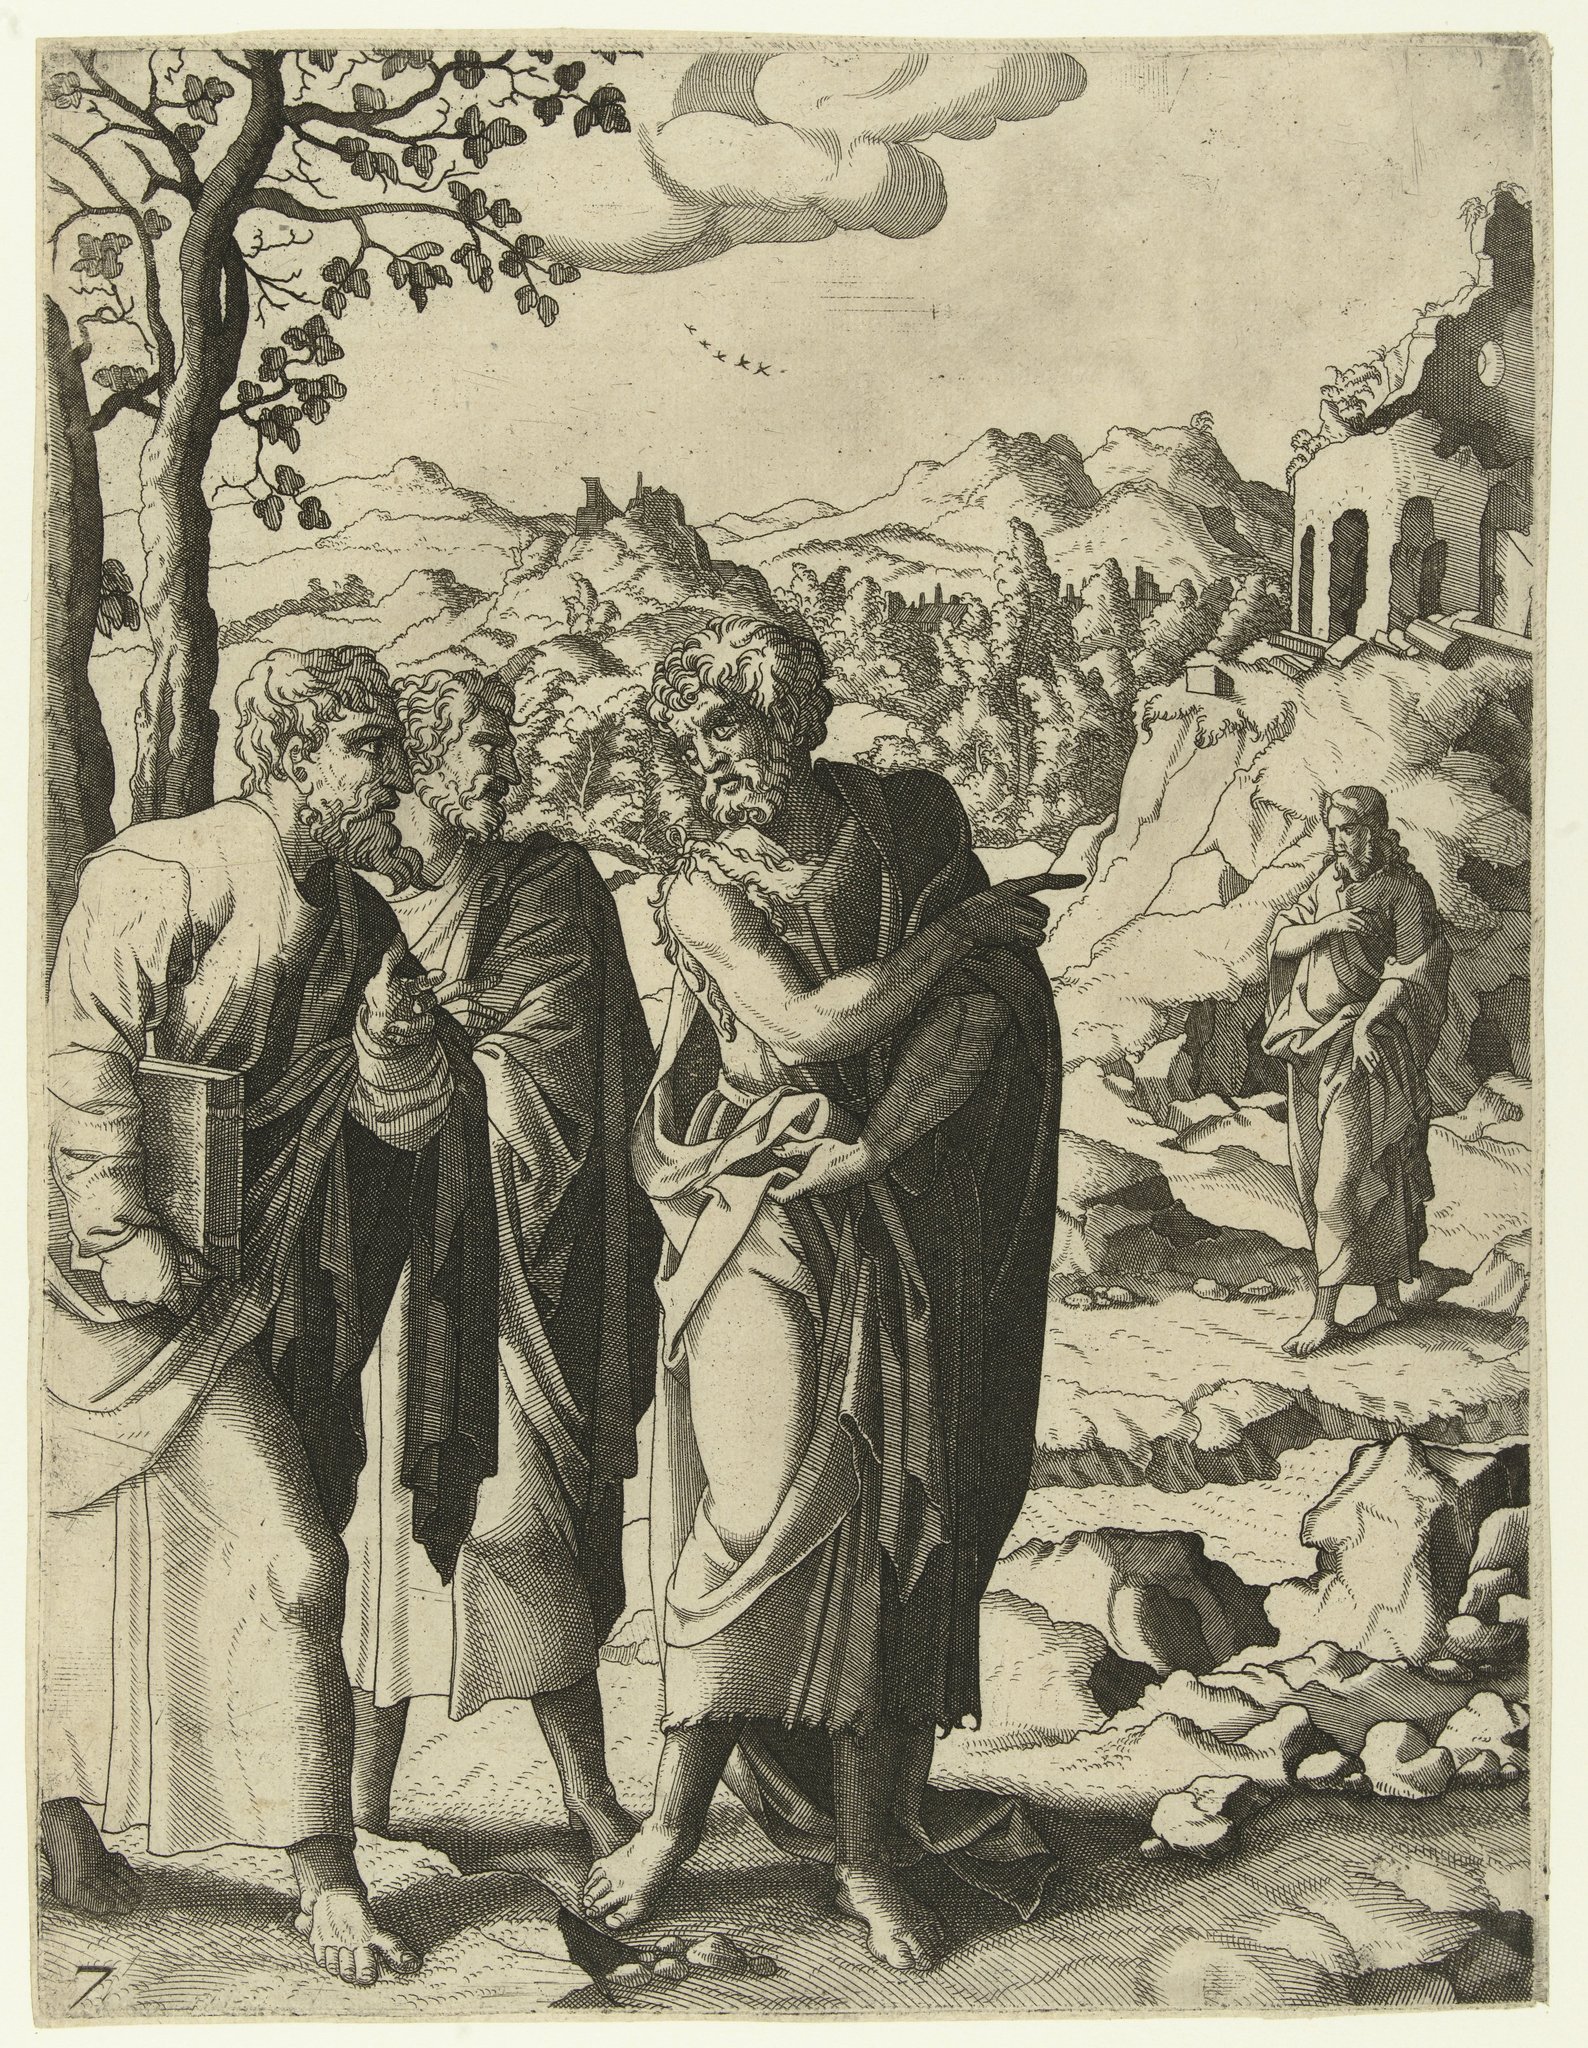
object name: print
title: Het leven van Johannes de Doper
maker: hans liefrinck (i)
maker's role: print maker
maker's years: 1518-1573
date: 1553-1558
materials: paper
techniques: etching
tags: story of john the baptist (matthew 3; mark 1:4-11; luke 3:1-22; john 1:19-34)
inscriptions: collector's mark: Lugt 2228a, collector's mark: Lugt 2760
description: Johannes met twee leerlingen, wijst naar Christus die aan komt lopen.